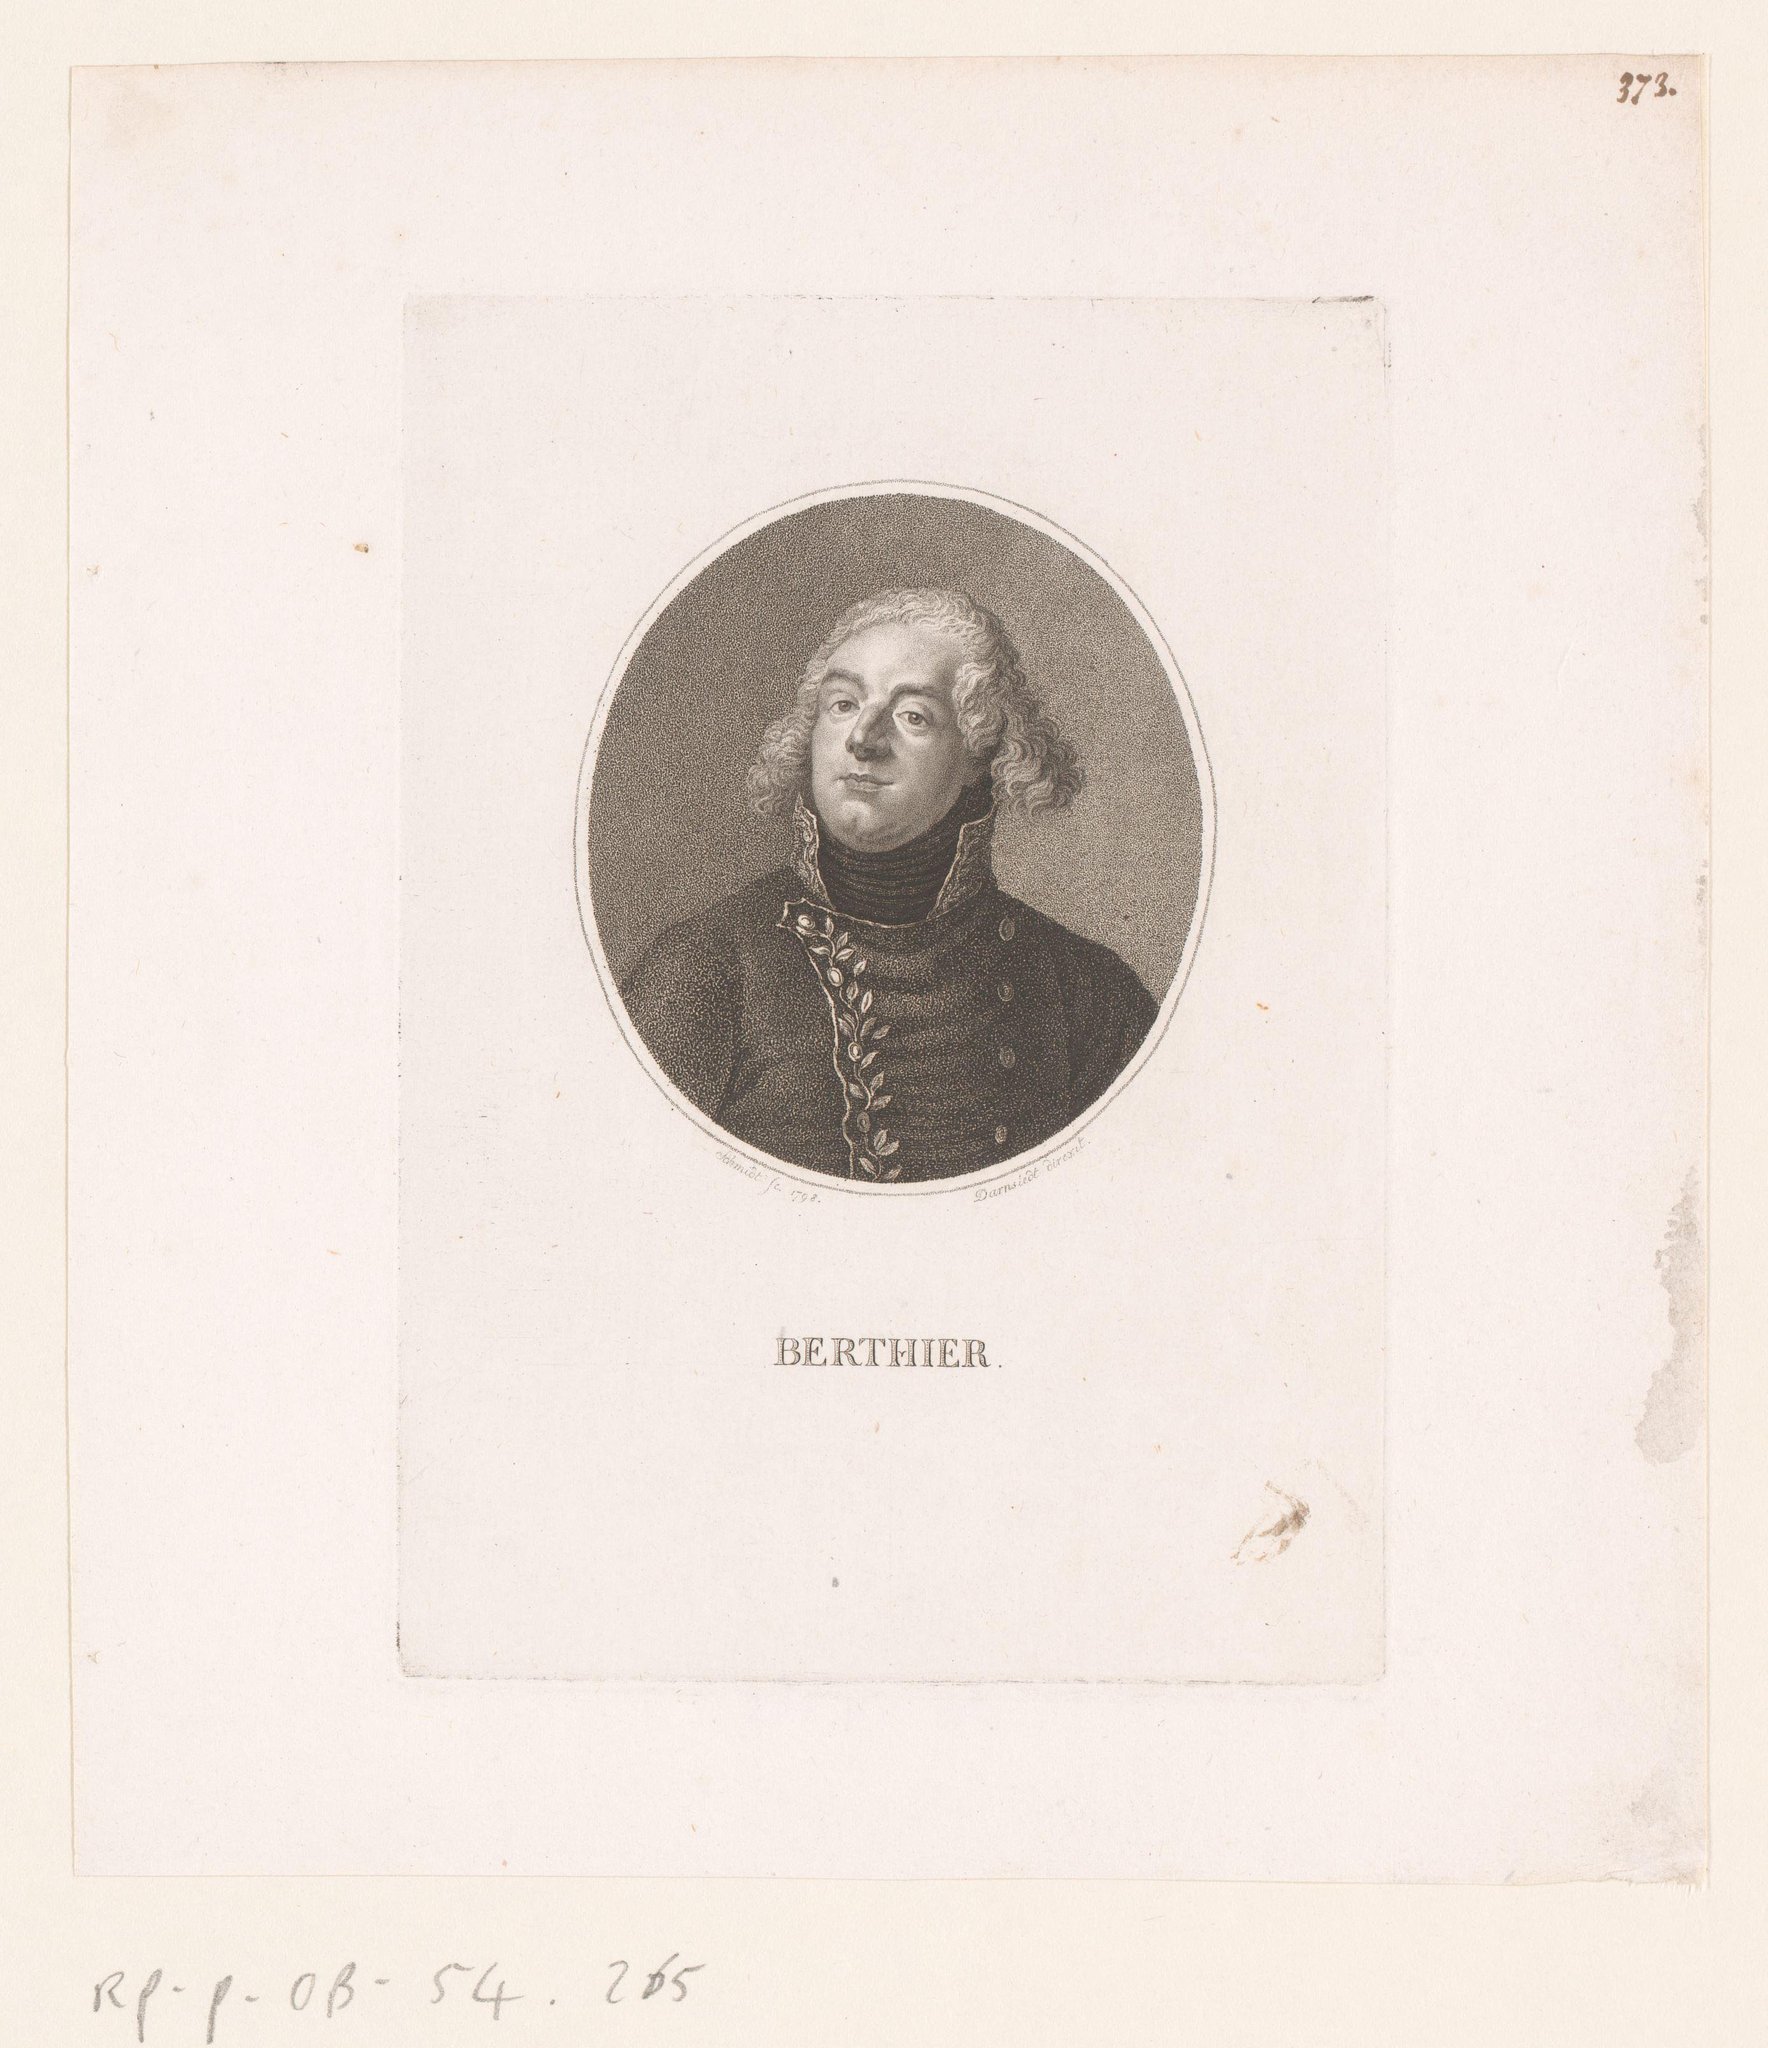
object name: print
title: Portret van Louis-Alexandre Berthier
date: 1750-1821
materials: paper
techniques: engraving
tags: historical persons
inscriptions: collector's mark: Lugt 2228